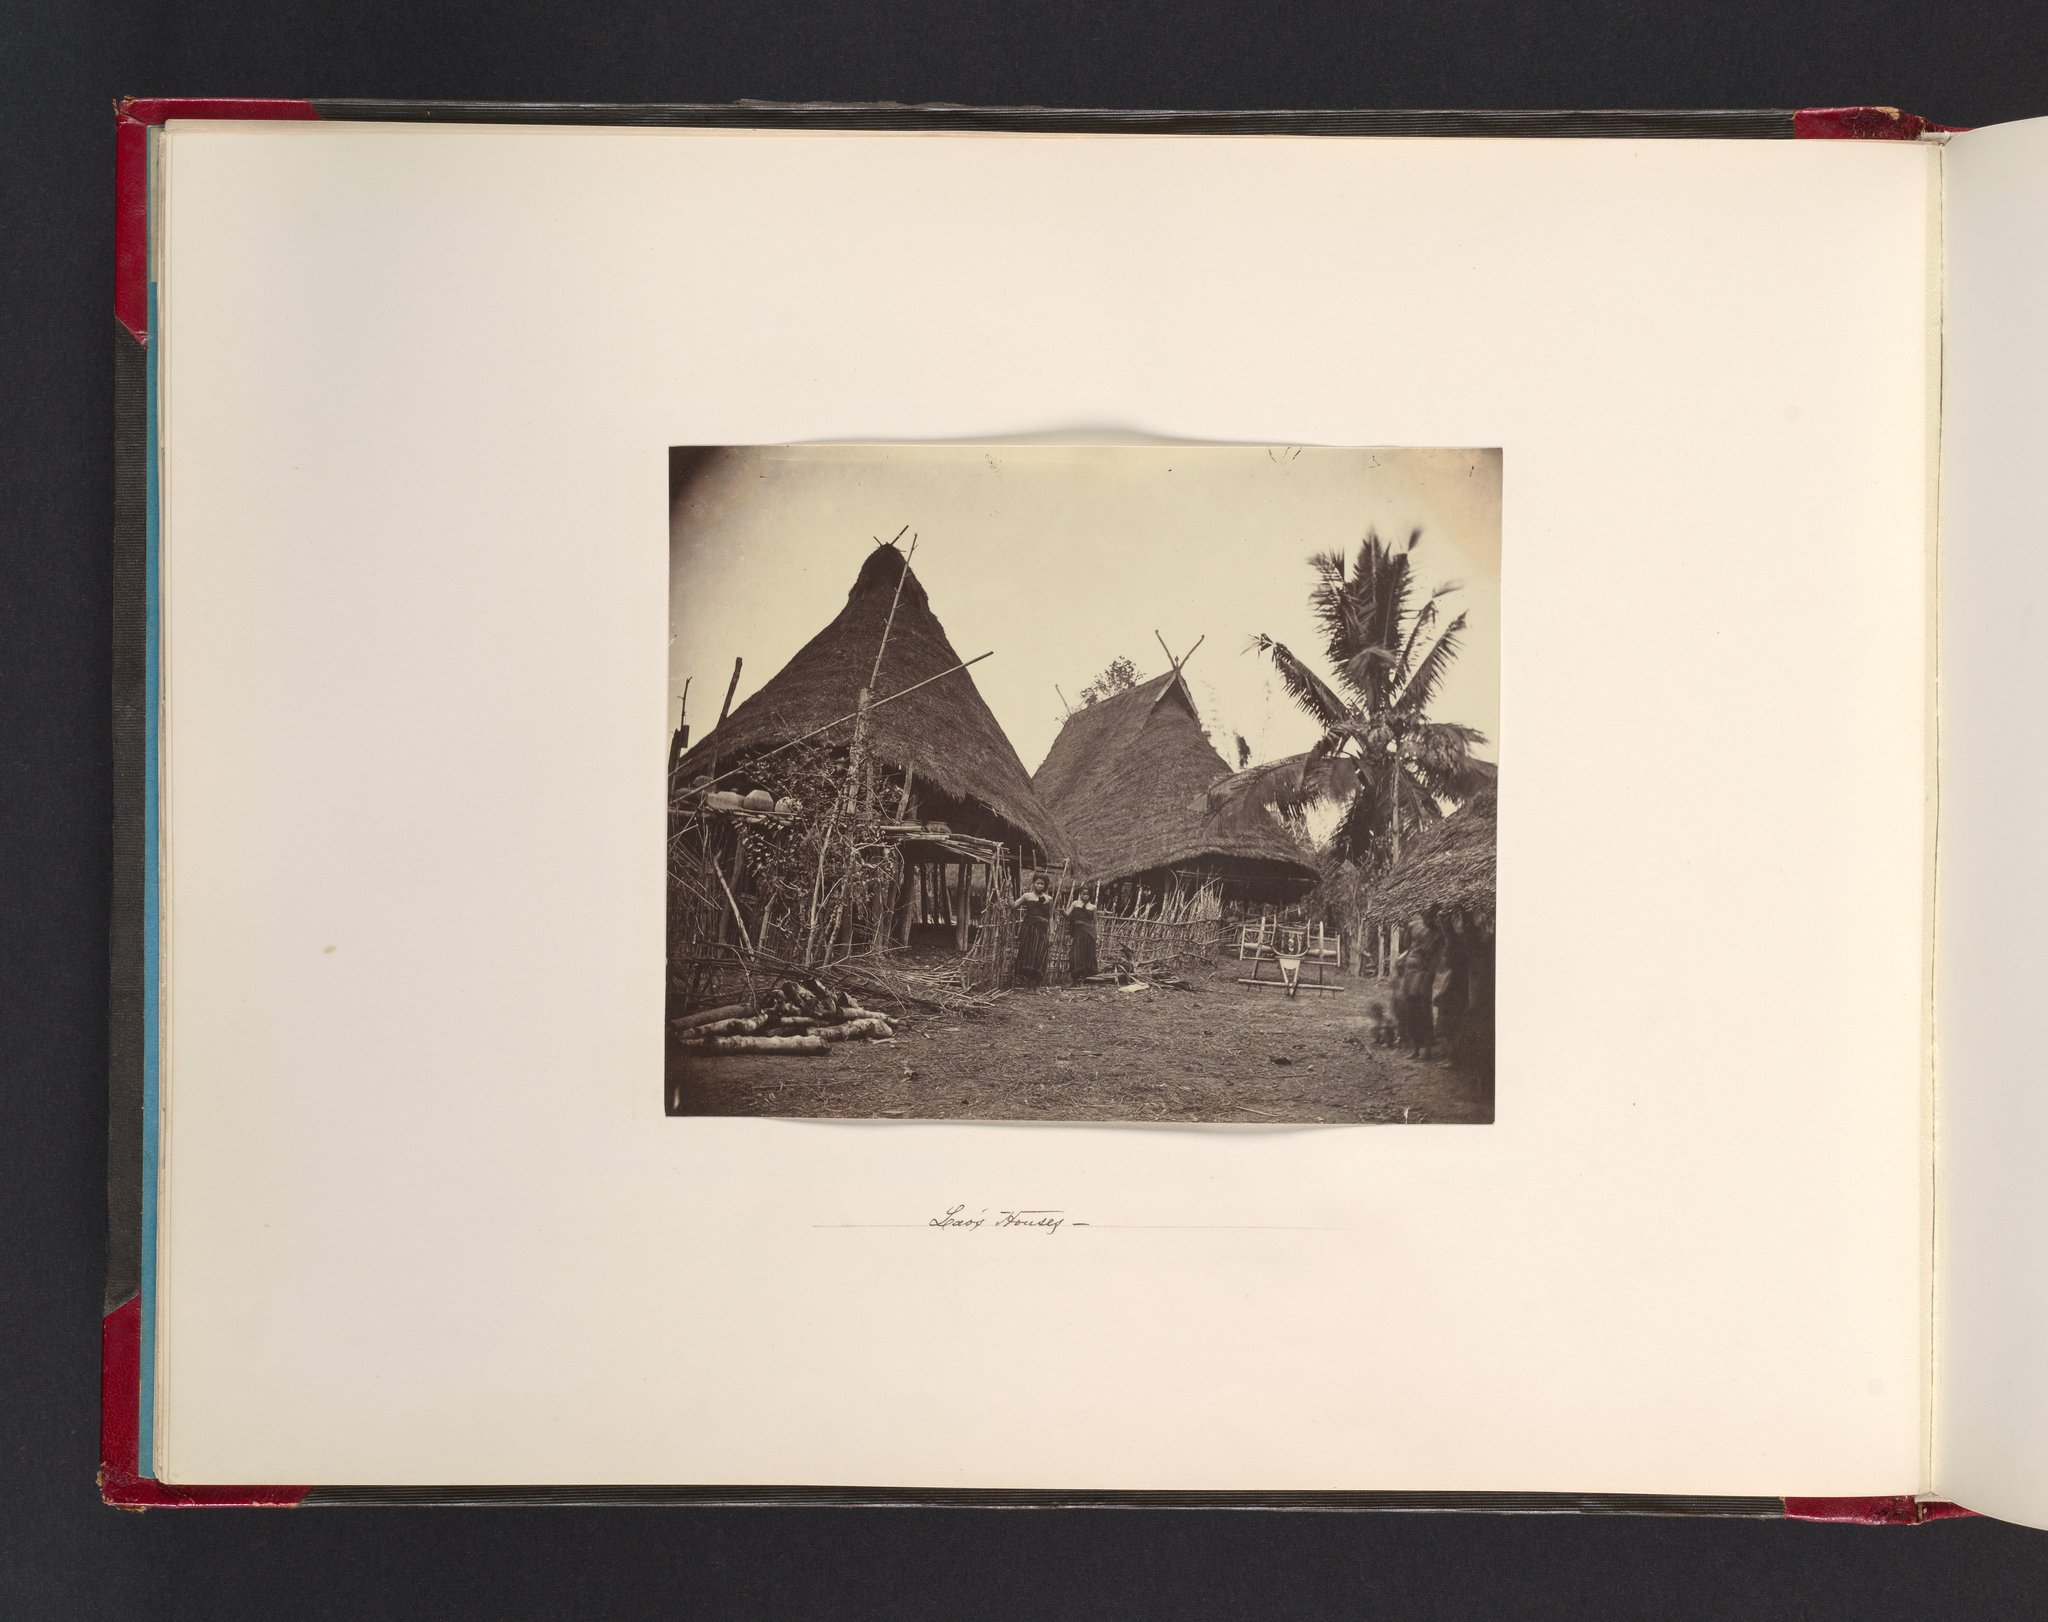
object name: photograph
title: Laos Houses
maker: john thomson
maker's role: artist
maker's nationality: british, scottish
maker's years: 1837-1921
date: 1865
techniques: albumen silver print, glass negative